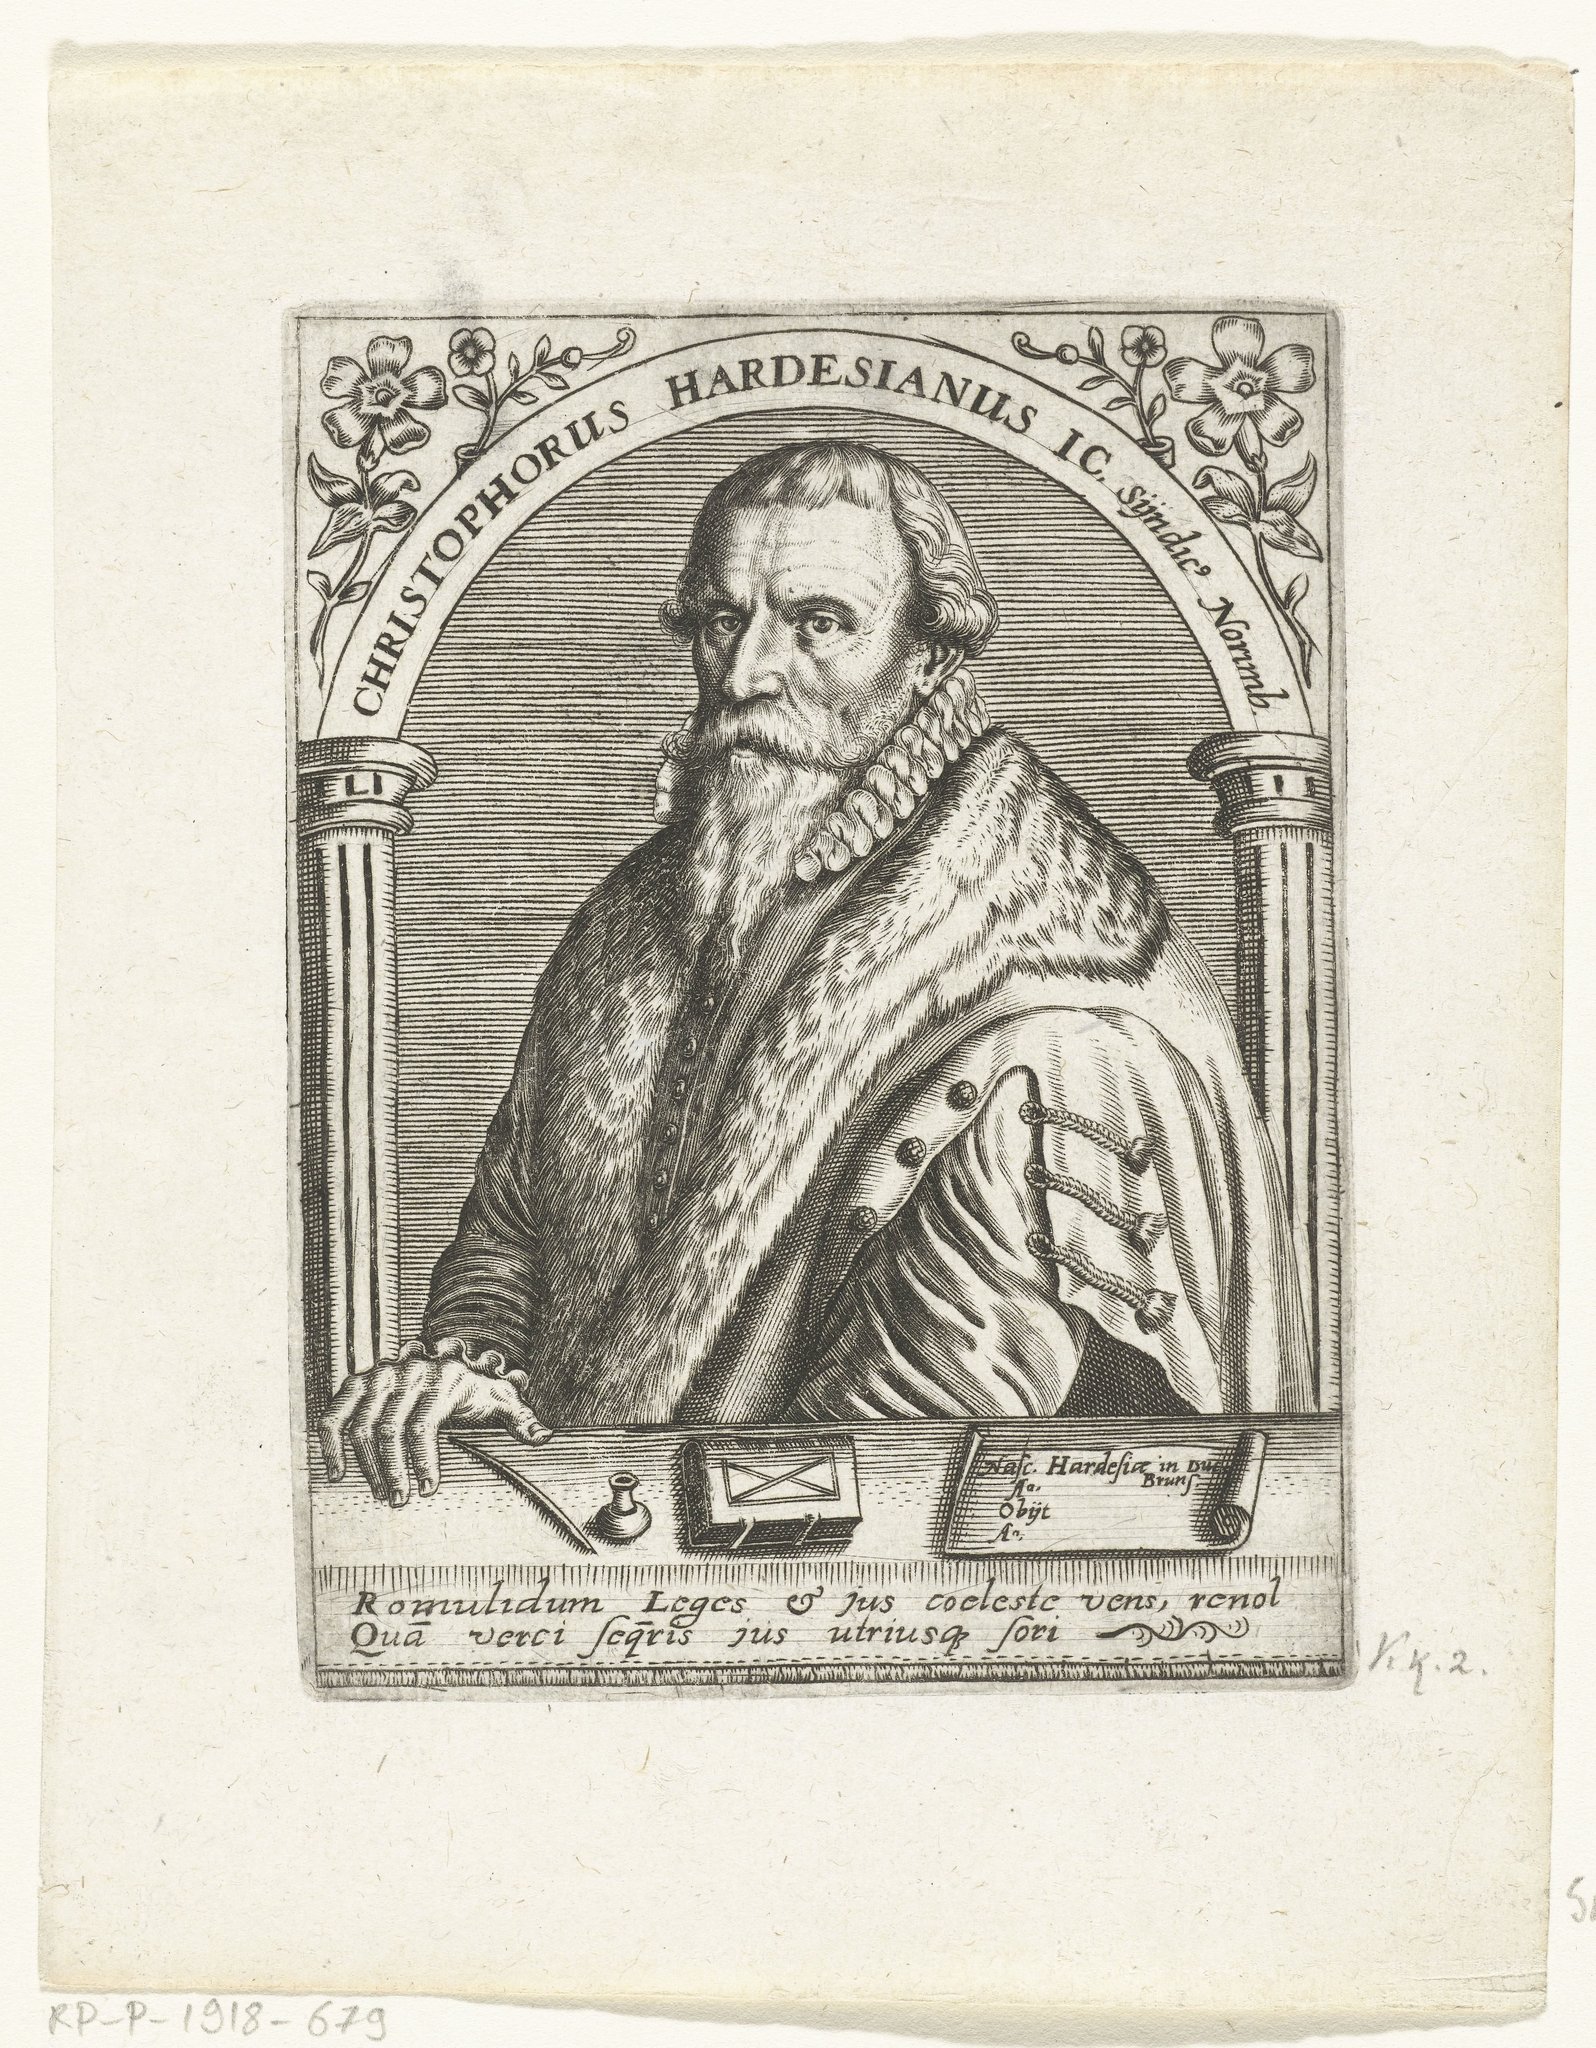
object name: book illustration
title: Christophorus Hardesianus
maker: jean jacques boissard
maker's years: 1528-1598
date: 1597-1599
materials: paper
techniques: engraving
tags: halberstadt, neurenberg, theoloog, rechtsgeleerde, christoph herdesianus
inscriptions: collector's mark: Lugt 2233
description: Portret van de Duitse rechtsgeleerde en theoloog Christoph Herdesianus, voor een nis aan een tafel. Op tafel ligt schrijfgerei en een boek. Onder het portret een Latijns vers.